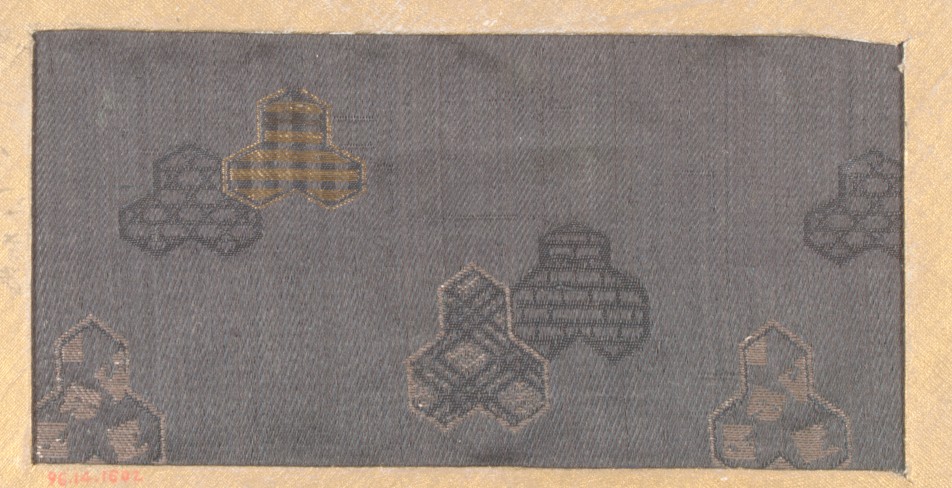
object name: piece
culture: japanese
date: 1701-1900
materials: silk